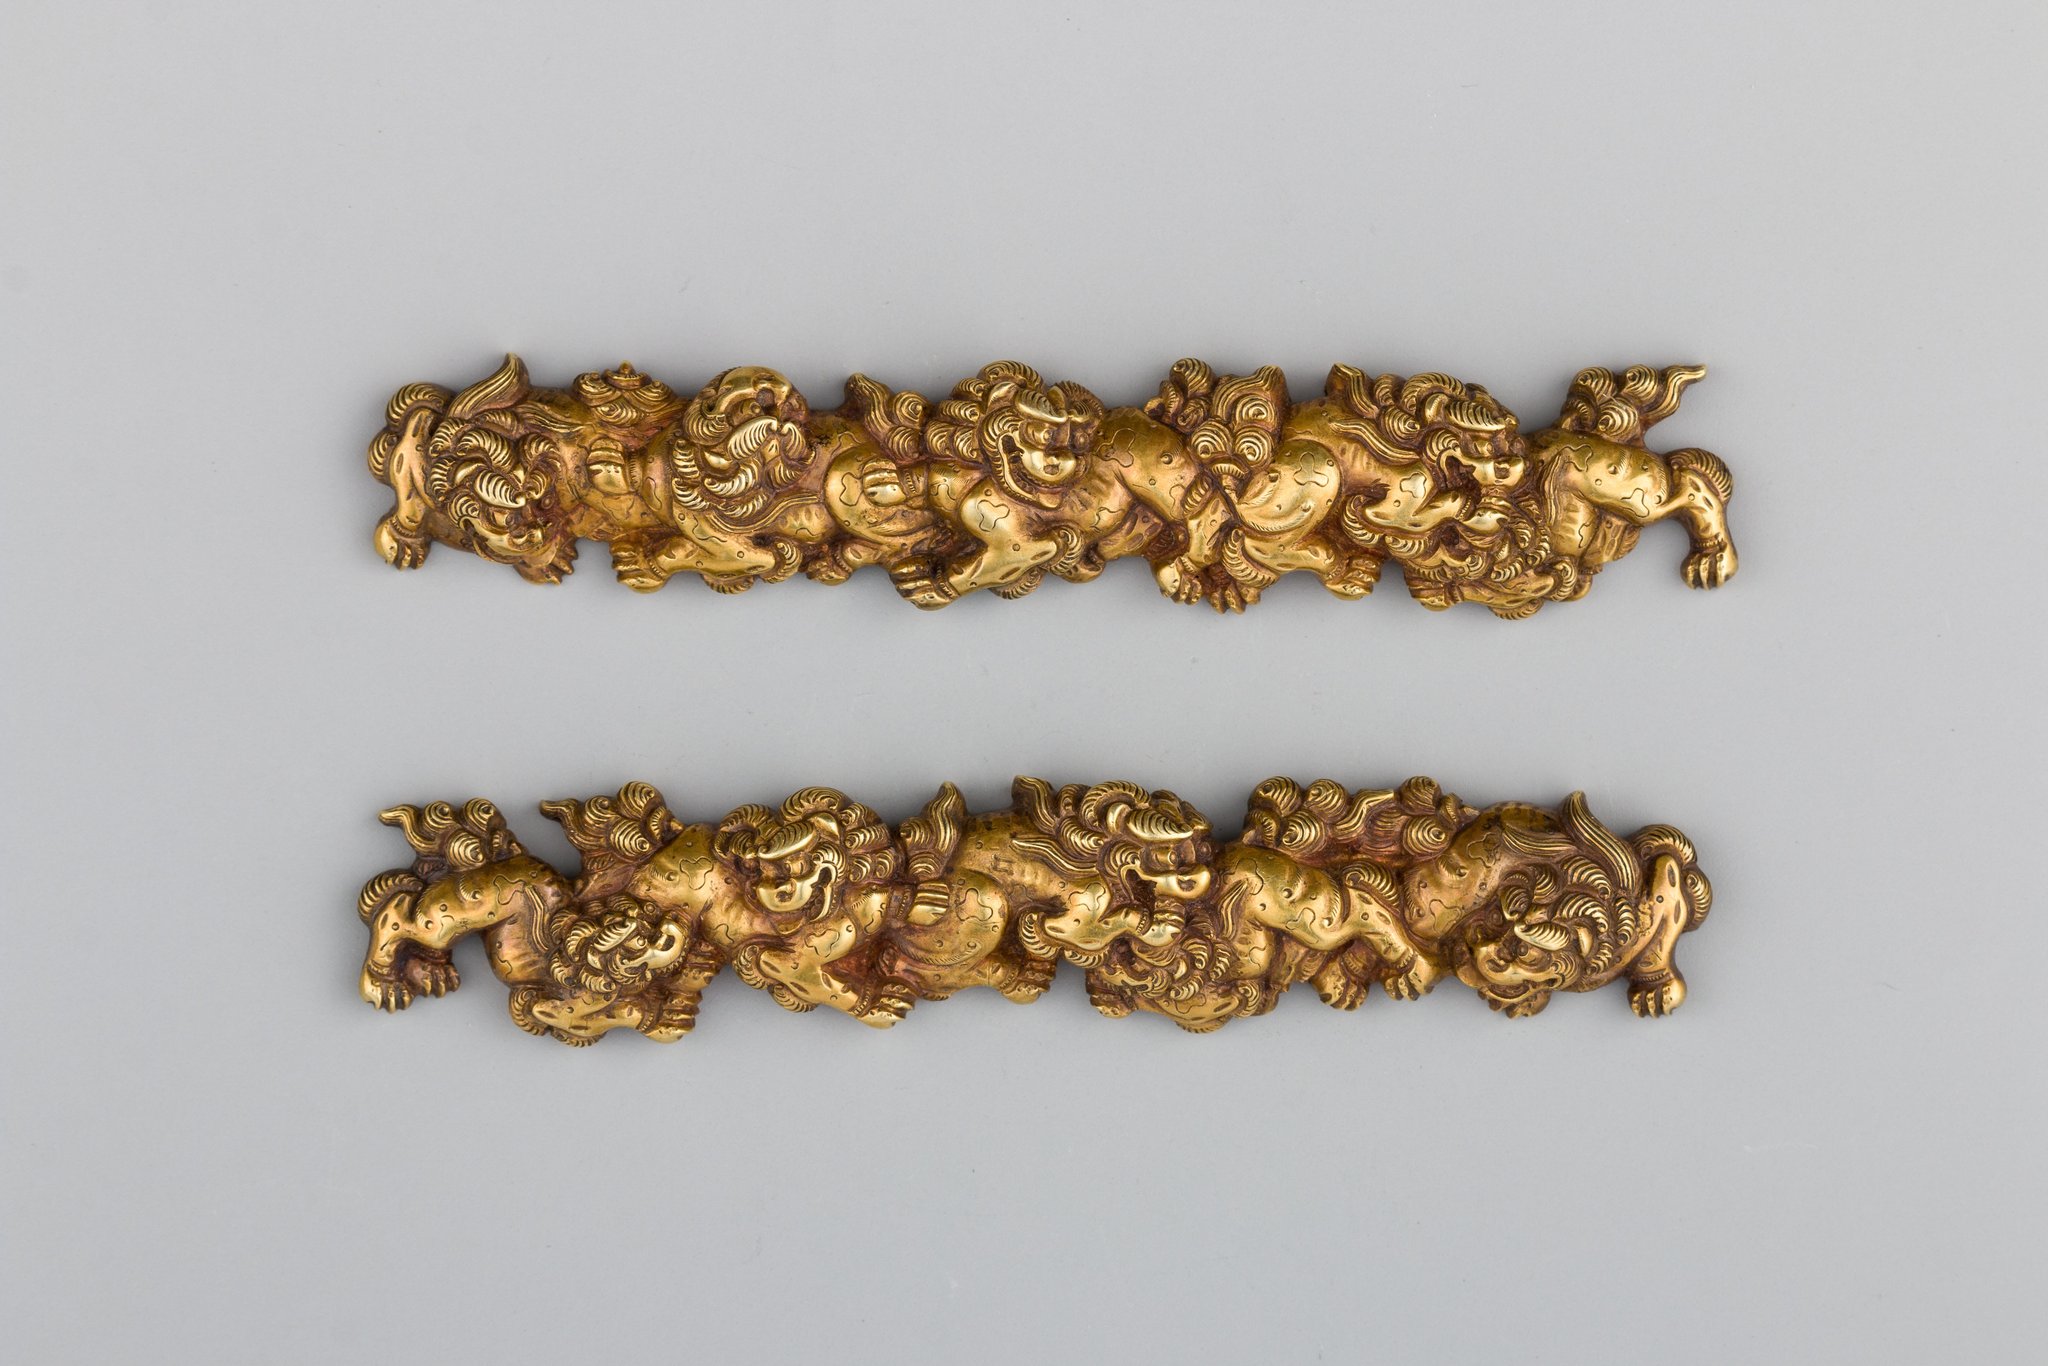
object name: pair of sword grip ornament menuki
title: Pair of Sword-Grip Ornaments (Menuki)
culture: japanese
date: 1601-1633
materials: gold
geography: japan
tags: lions